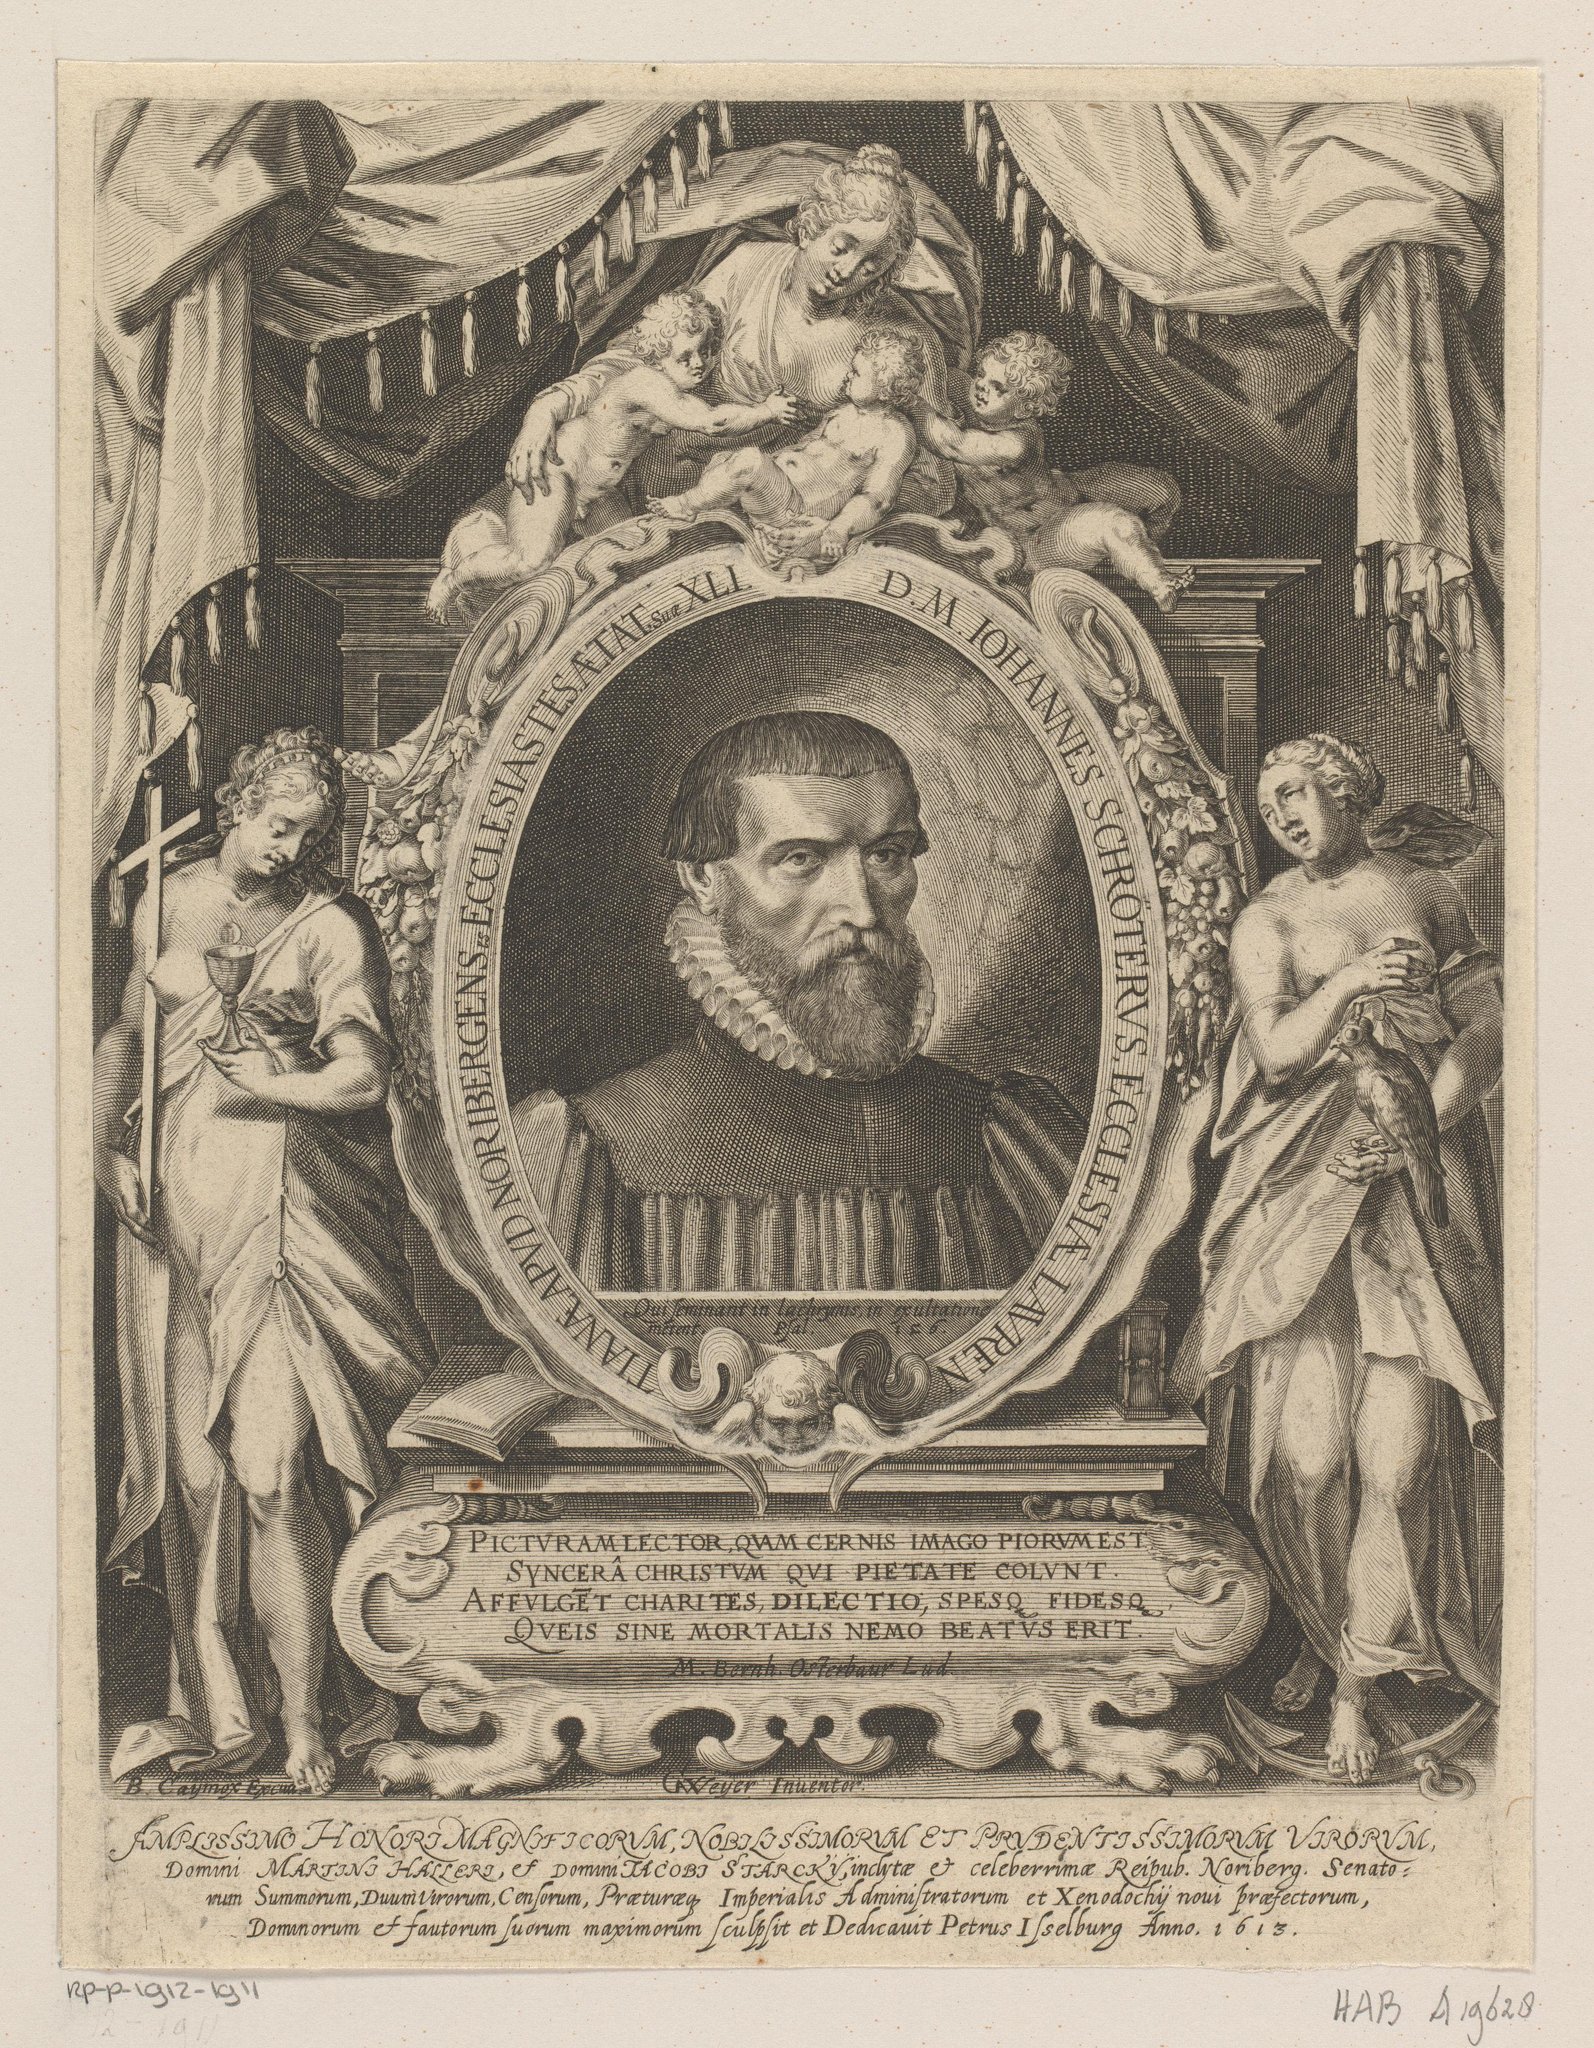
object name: print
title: Portret van Johann Schröder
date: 1613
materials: paper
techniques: engraving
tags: theologian, historical persons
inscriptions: collector's mark: Lugt 2228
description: Deze prent maakt mogelijk onderdeel uit van een serie met portretten van predikanten en theologen, naar ontwerp van Gabriel Weyer.